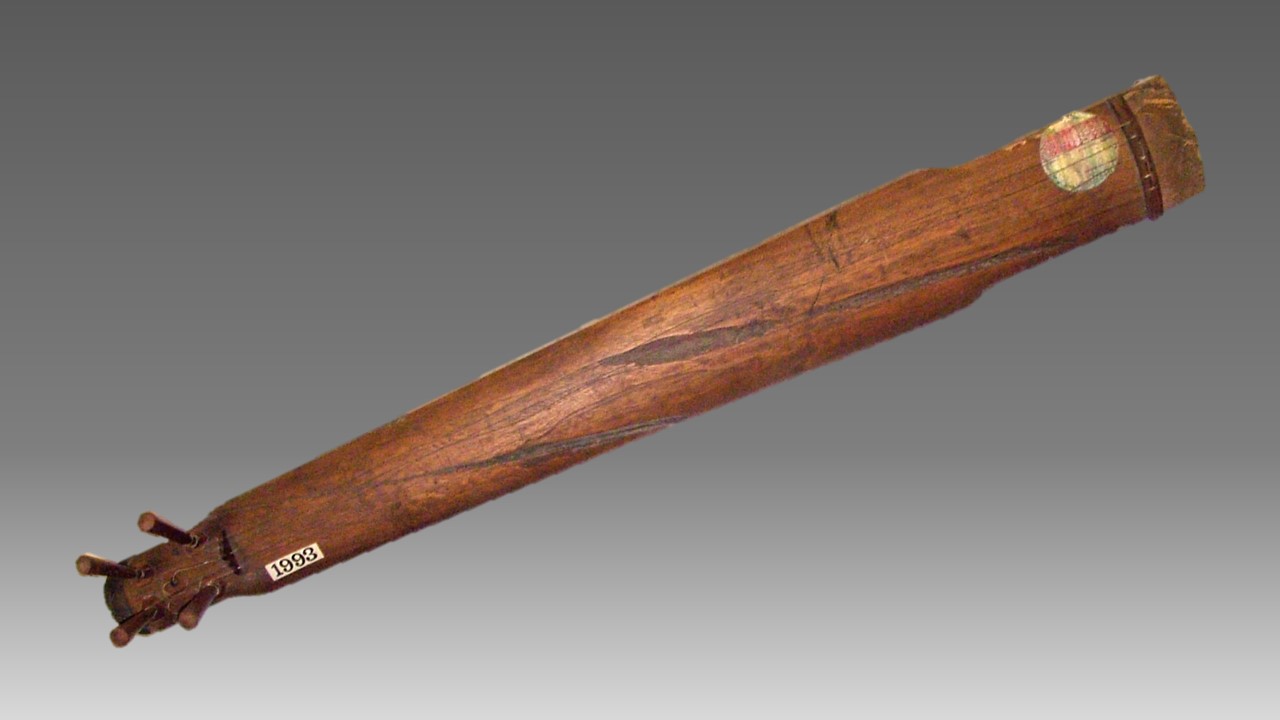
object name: gogenkin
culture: japanese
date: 1801-1900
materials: silk, wood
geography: japan